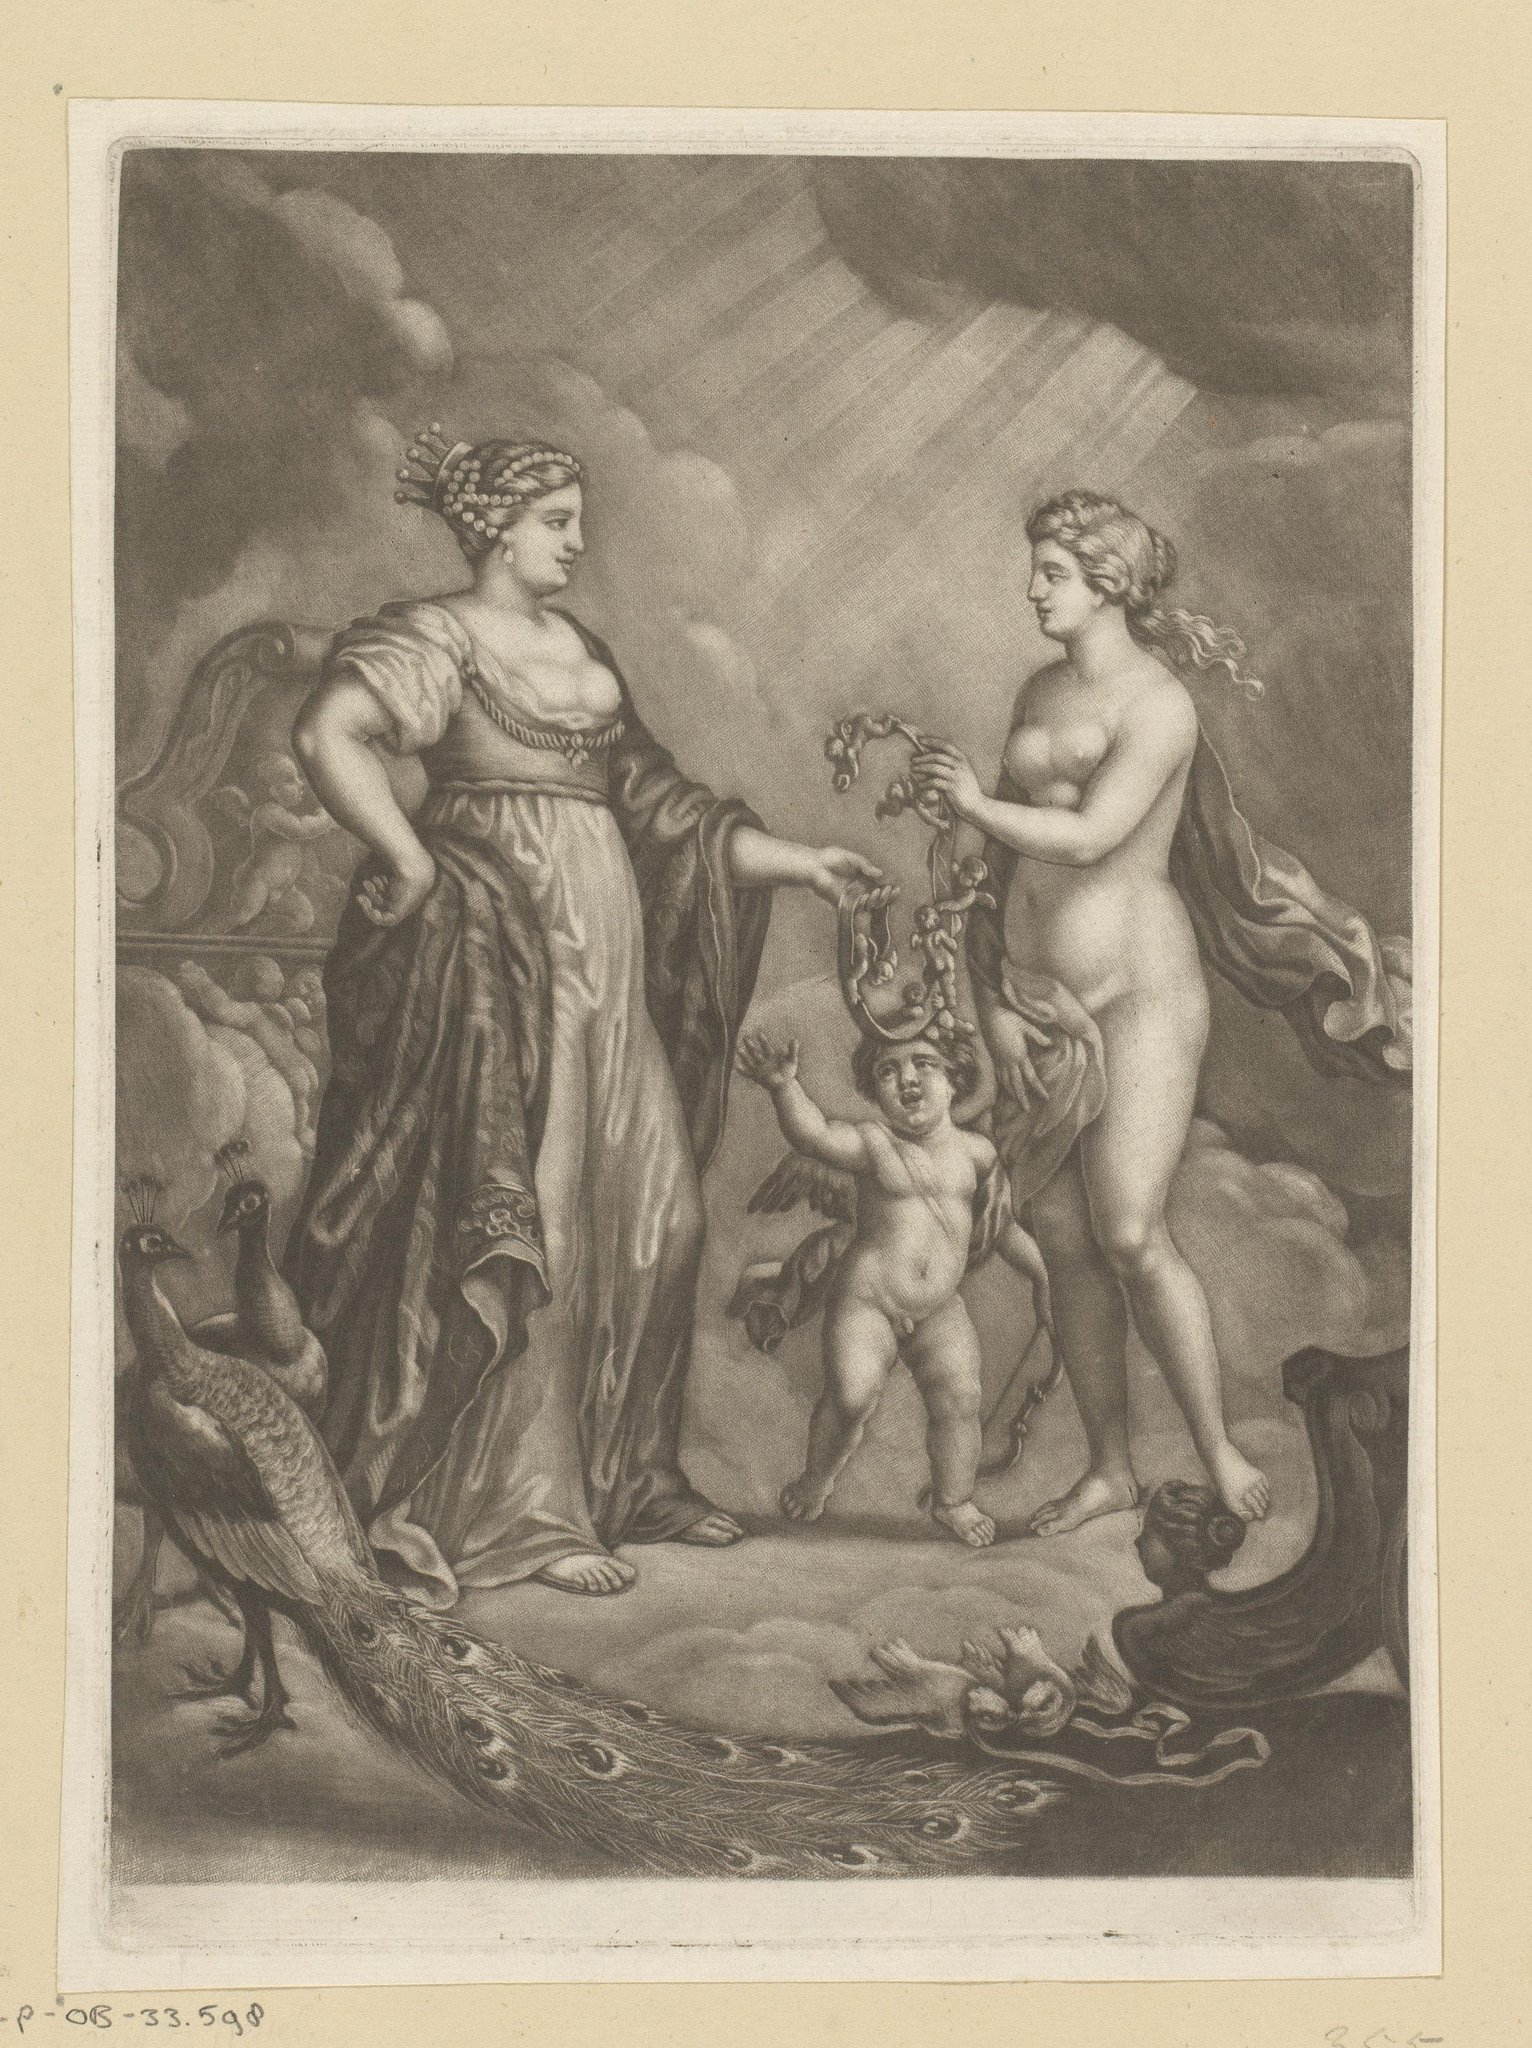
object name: print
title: Venus geeft haar gordel aan Juno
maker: Anonymous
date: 1680-1720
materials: paper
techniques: mezzotint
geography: england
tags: juno requests venus' girdle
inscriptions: collector's mark: Lugt 240